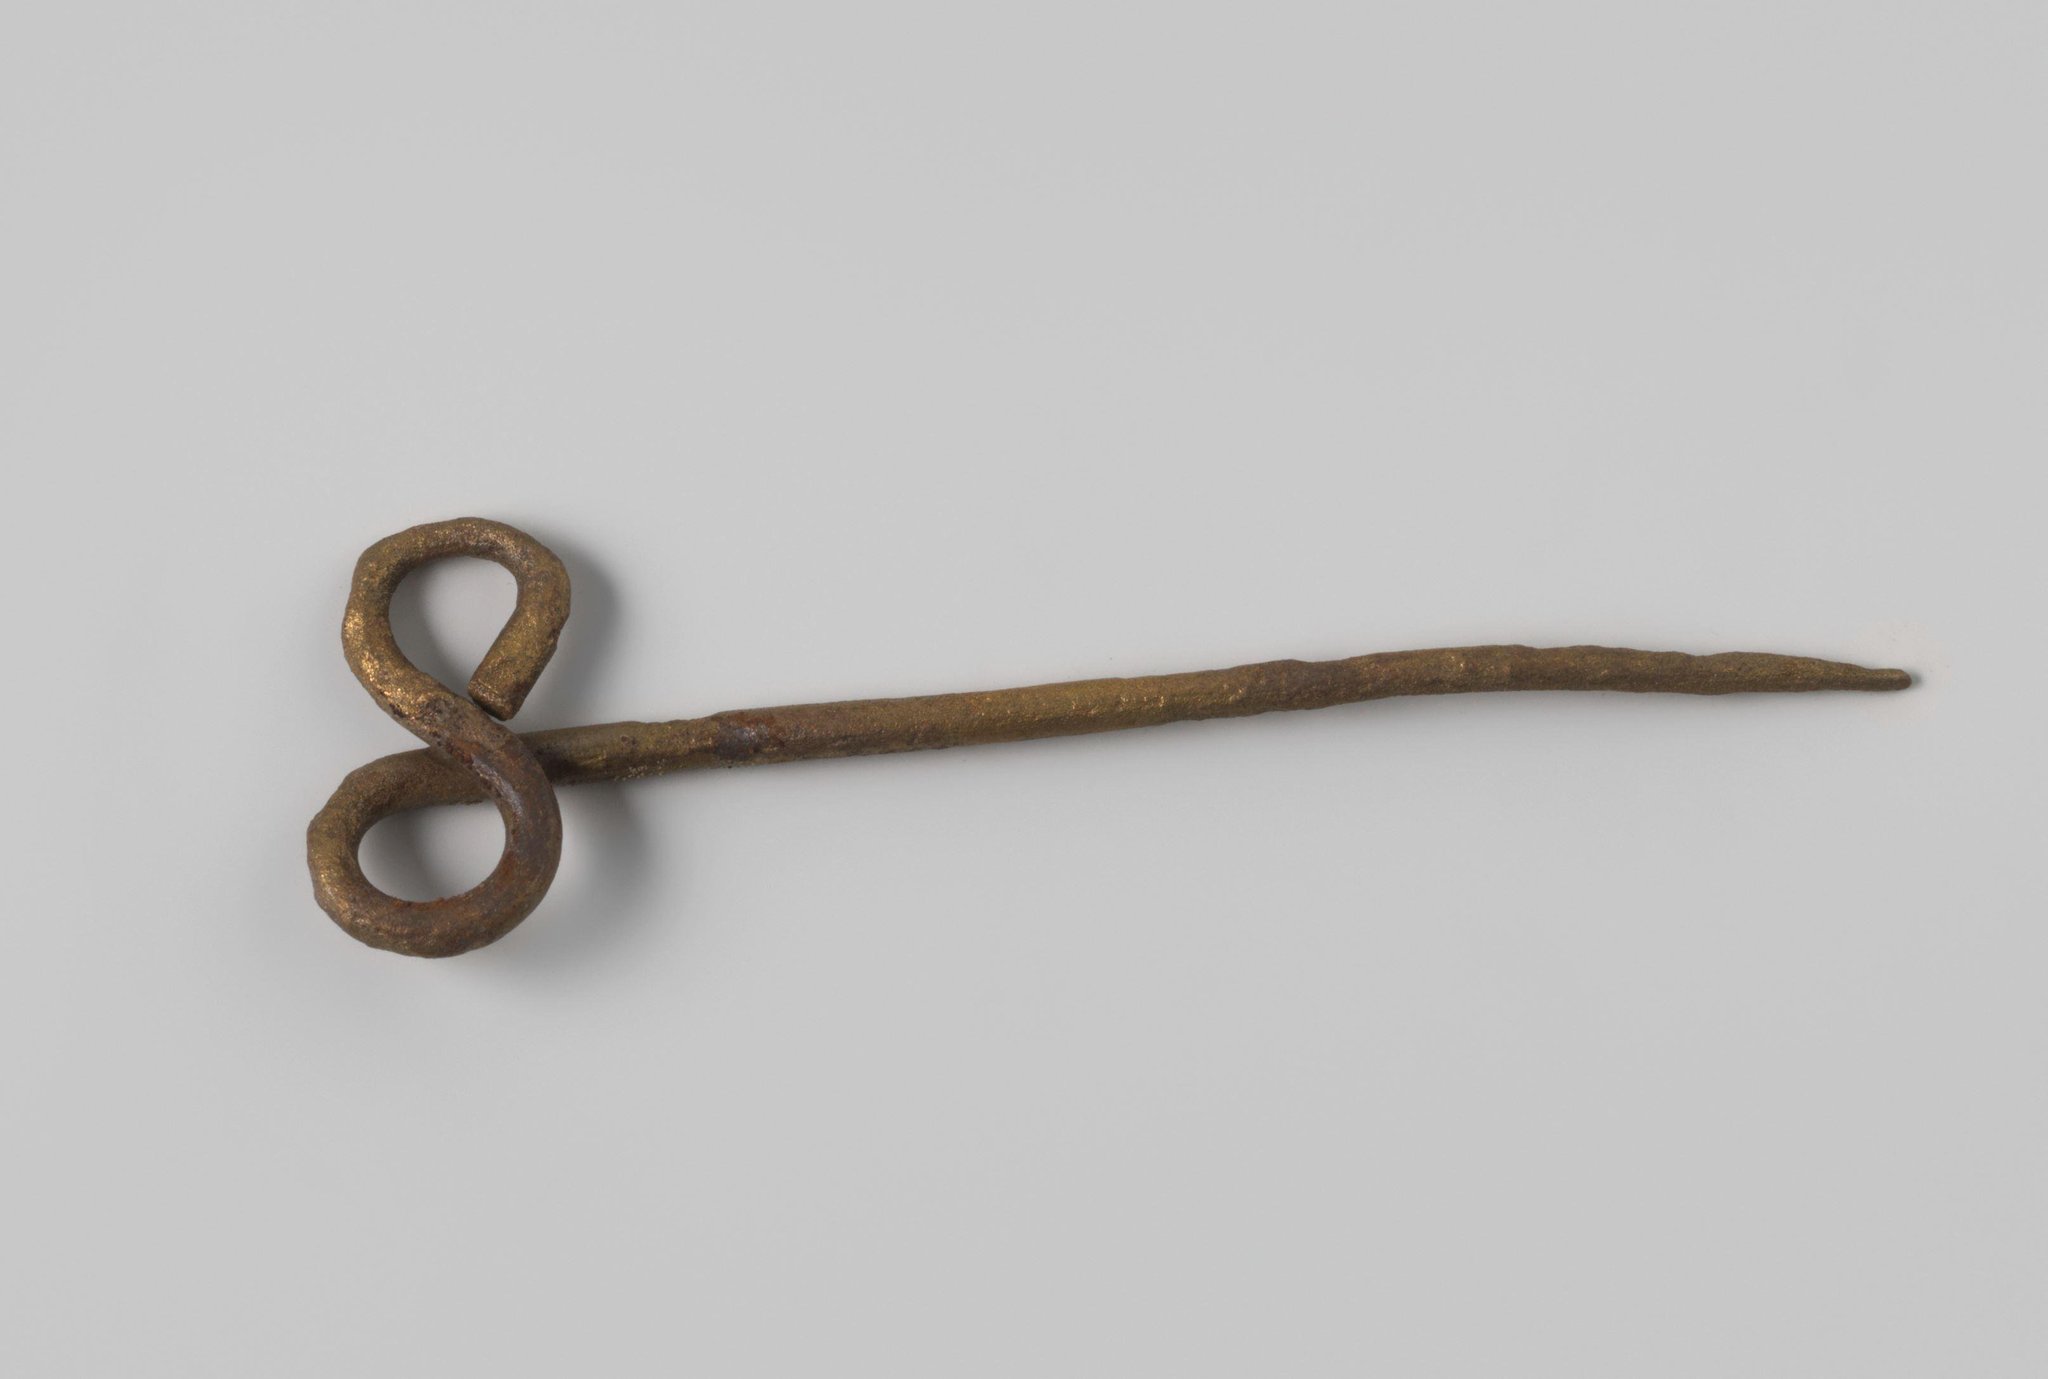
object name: priming wire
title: Laadpriem uit het wrak van de Oost-Indiëvaarder Hollandia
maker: Anonymous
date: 1700-1743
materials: copper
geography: netherlands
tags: verenigde oostindische compagnie, hollandia (schip), annet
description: Priming wire; fragm, upper end, shaft eroded, id. NG 1975-17H374.